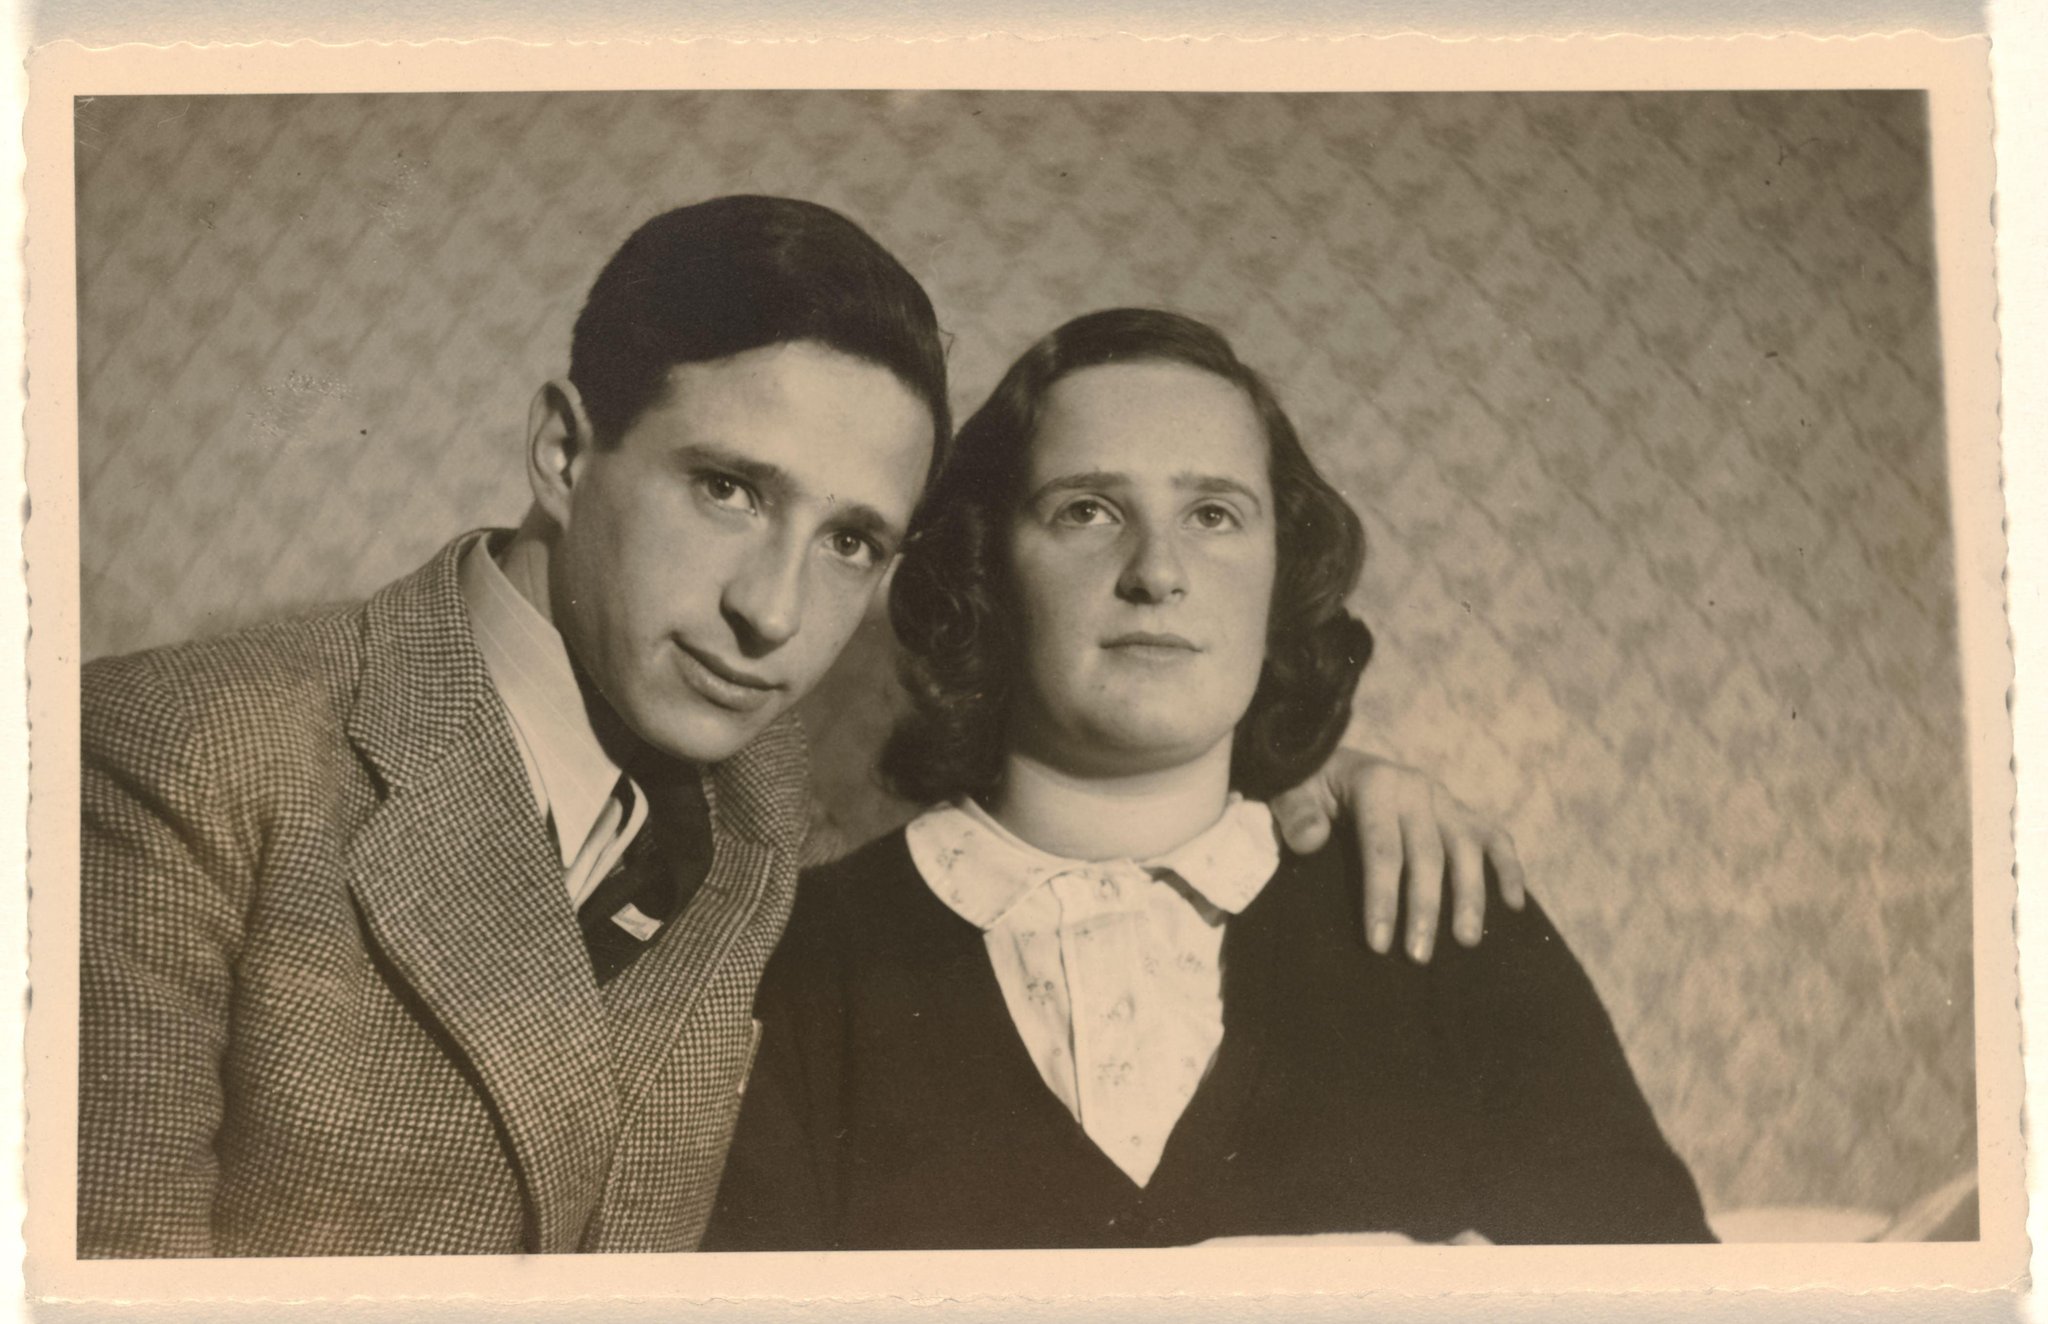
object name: photograph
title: Photographs from the Estate of Isabel Wachenheimer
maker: Anonymous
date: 1947-1956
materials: photographic support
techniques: gelatin silver print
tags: buchenwald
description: Isabel Wachenheimer still signed with her concentration camp number, ‘K.Z. häftling No 918’ three months after she was liberated. Just see the inscription on the back of a portrait photograph of her taken on 25 September 1945. Isabel was a broken person after the war. She slowly recuperated from a fractured vertebra in Davos (Switzerland). In November 1946 Isabel married Leo Blumensohn, a fellow victim she met in the Westerbork transit camp.